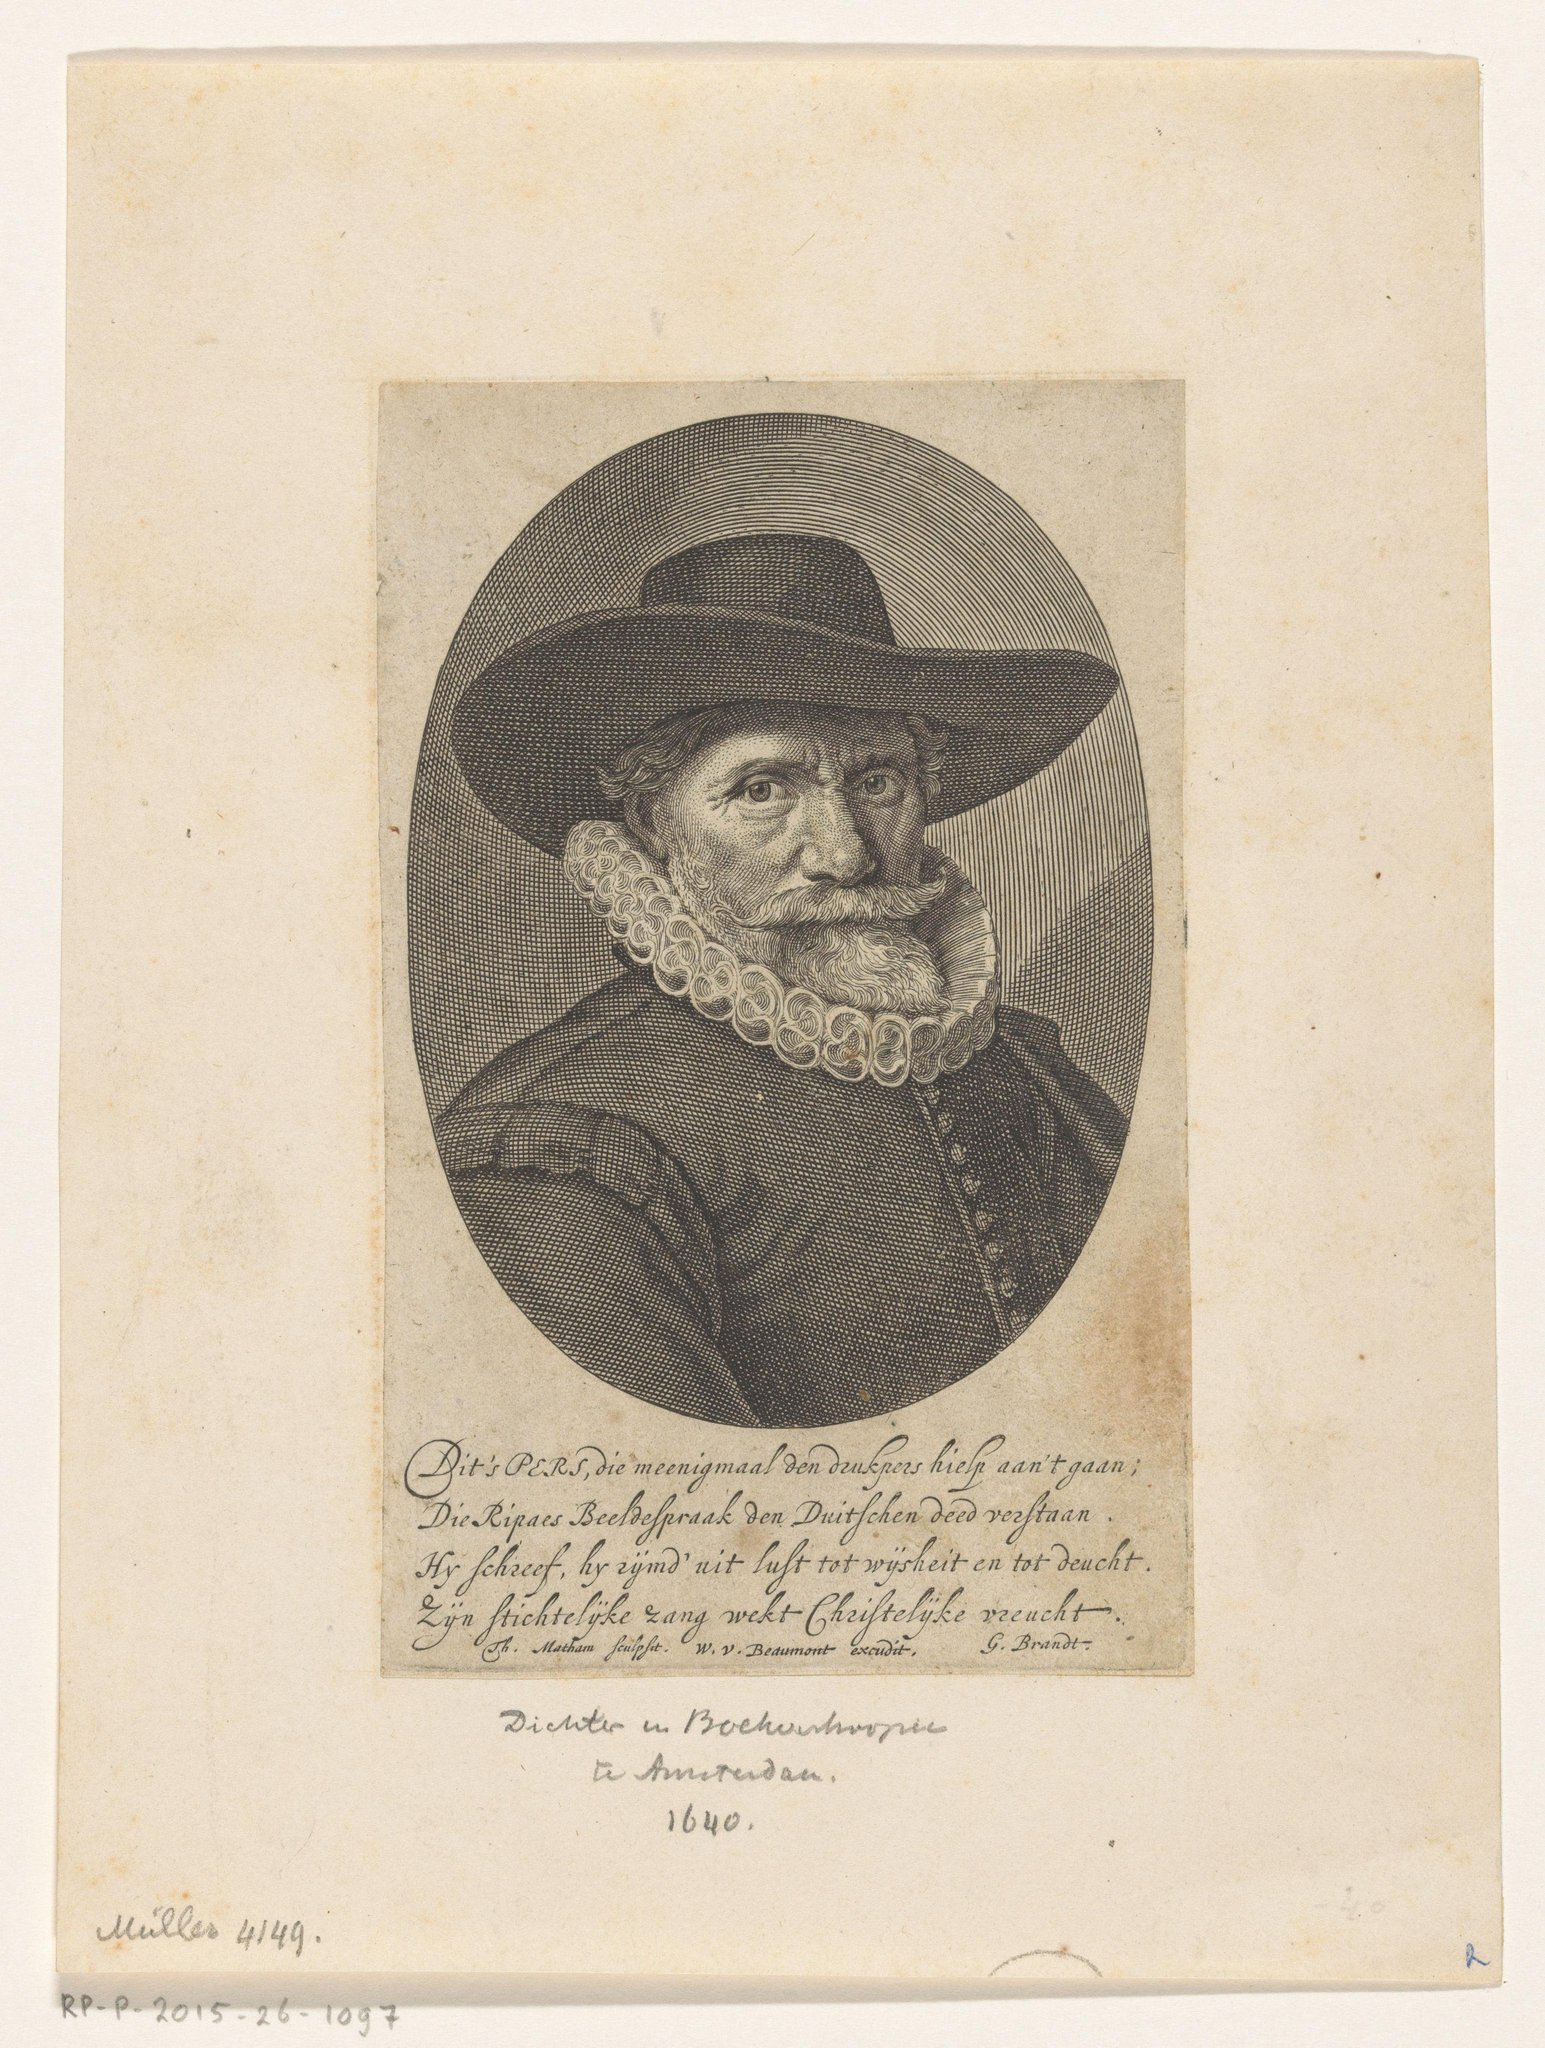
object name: print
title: Portret van Dirck Pietersz Pers, dichter en boekverkoper te Amsterdam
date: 1655-1676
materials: paper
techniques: engraving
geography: amsterdam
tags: publisher, dirck pietersz. pers, writer, poet, author, book-shop, bookseller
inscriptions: collector's mark: Lugt 4780, collector's mark: Lugt 2228